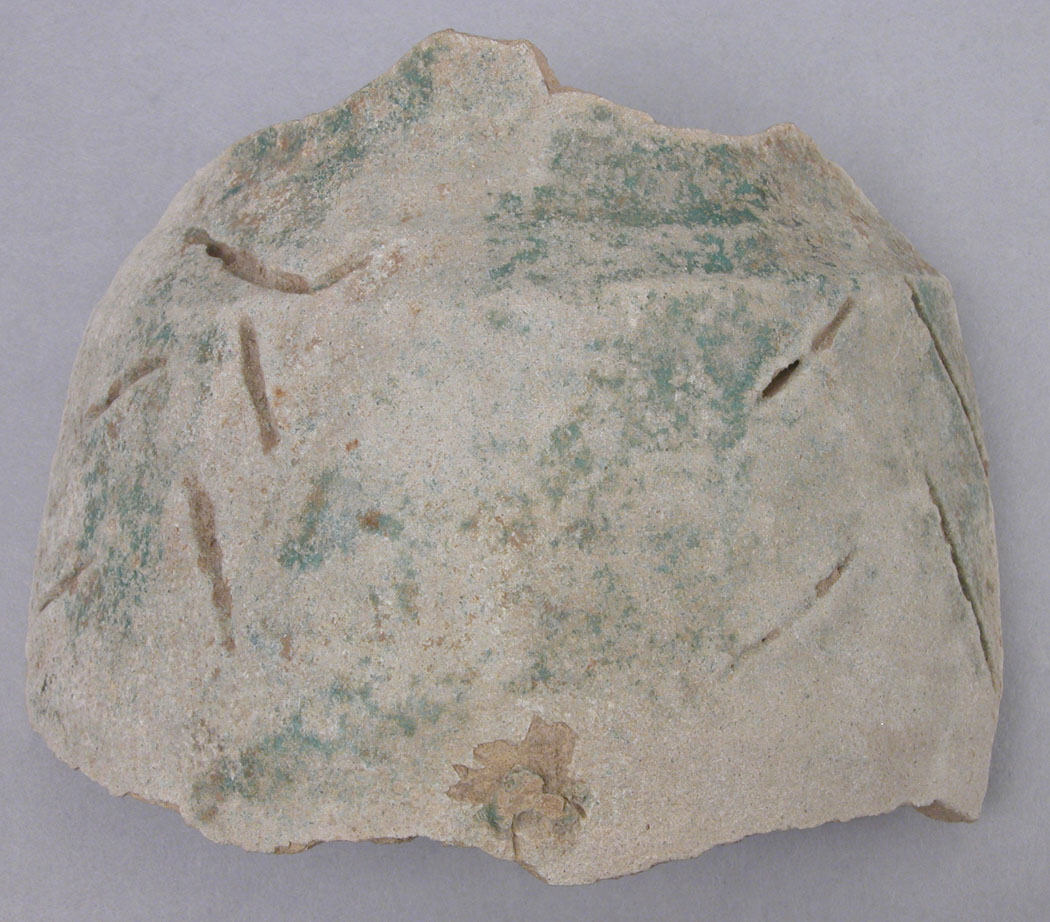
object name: fragment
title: Ceramic Fragment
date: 201-800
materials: earthenware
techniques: glazing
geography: iraq